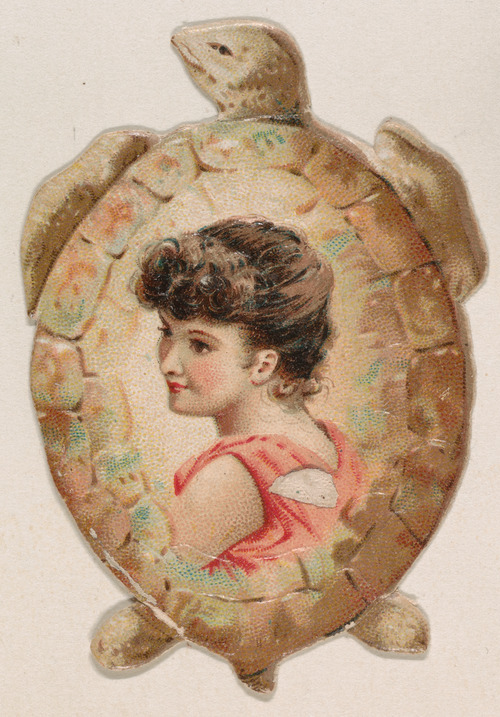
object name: print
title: Turtle, from the Novelties series (N228, Type 4) issued by Kinney Bros.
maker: kinney brothers tobacco company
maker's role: publisher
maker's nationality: american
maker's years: 1869-2011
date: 1889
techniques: color lithograph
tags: women,turtles